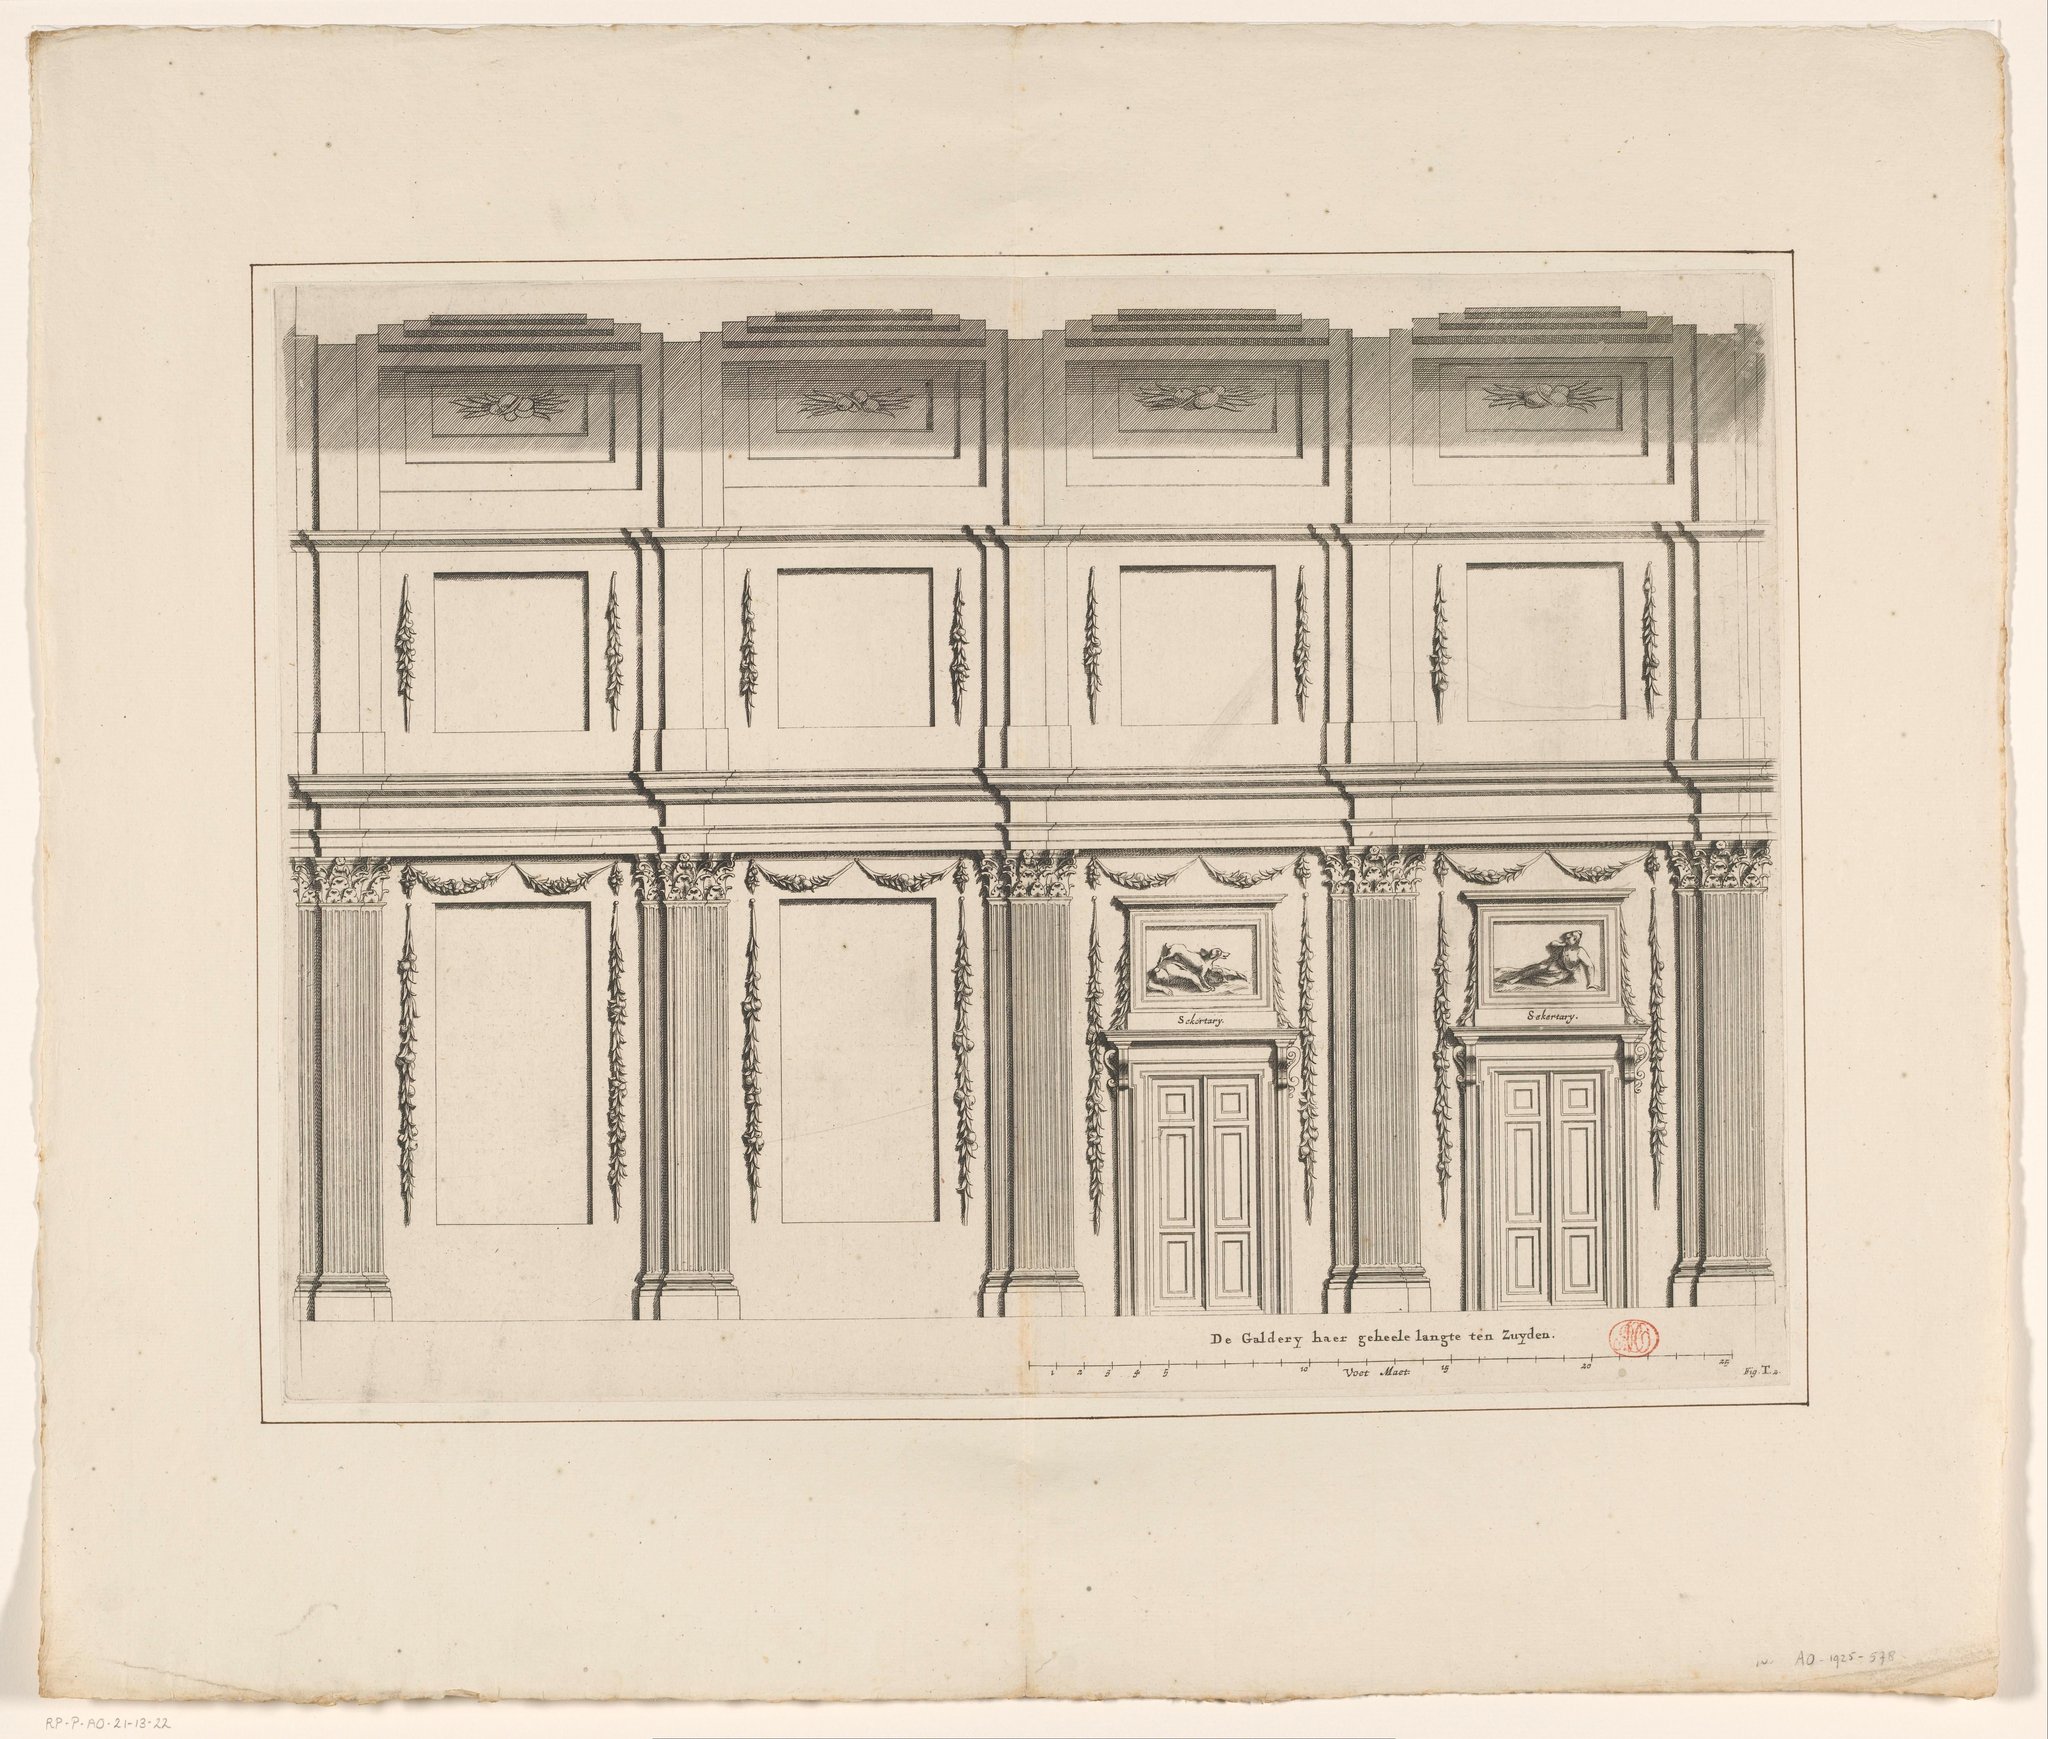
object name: book illustration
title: Zuidelijke galerij in het Stadhuis op de Dam (middelste deel)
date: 1661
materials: paper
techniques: engraving, etching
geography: amsterdam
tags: interior ~ architectural design or model, townhall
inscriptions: collector's mark: Lugt 195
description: Middelste deel van een prent van de zuidelijke galerij in het Stadhuis op de Dam te Amsterdam, bestaande uit drie delen. Rechts van het midden de twee deuren naar het Secretarie. Daaronder de titel en een schaalstok: 25 Voet Maet. Rechtsonder genummerd: Fig. T. 2.